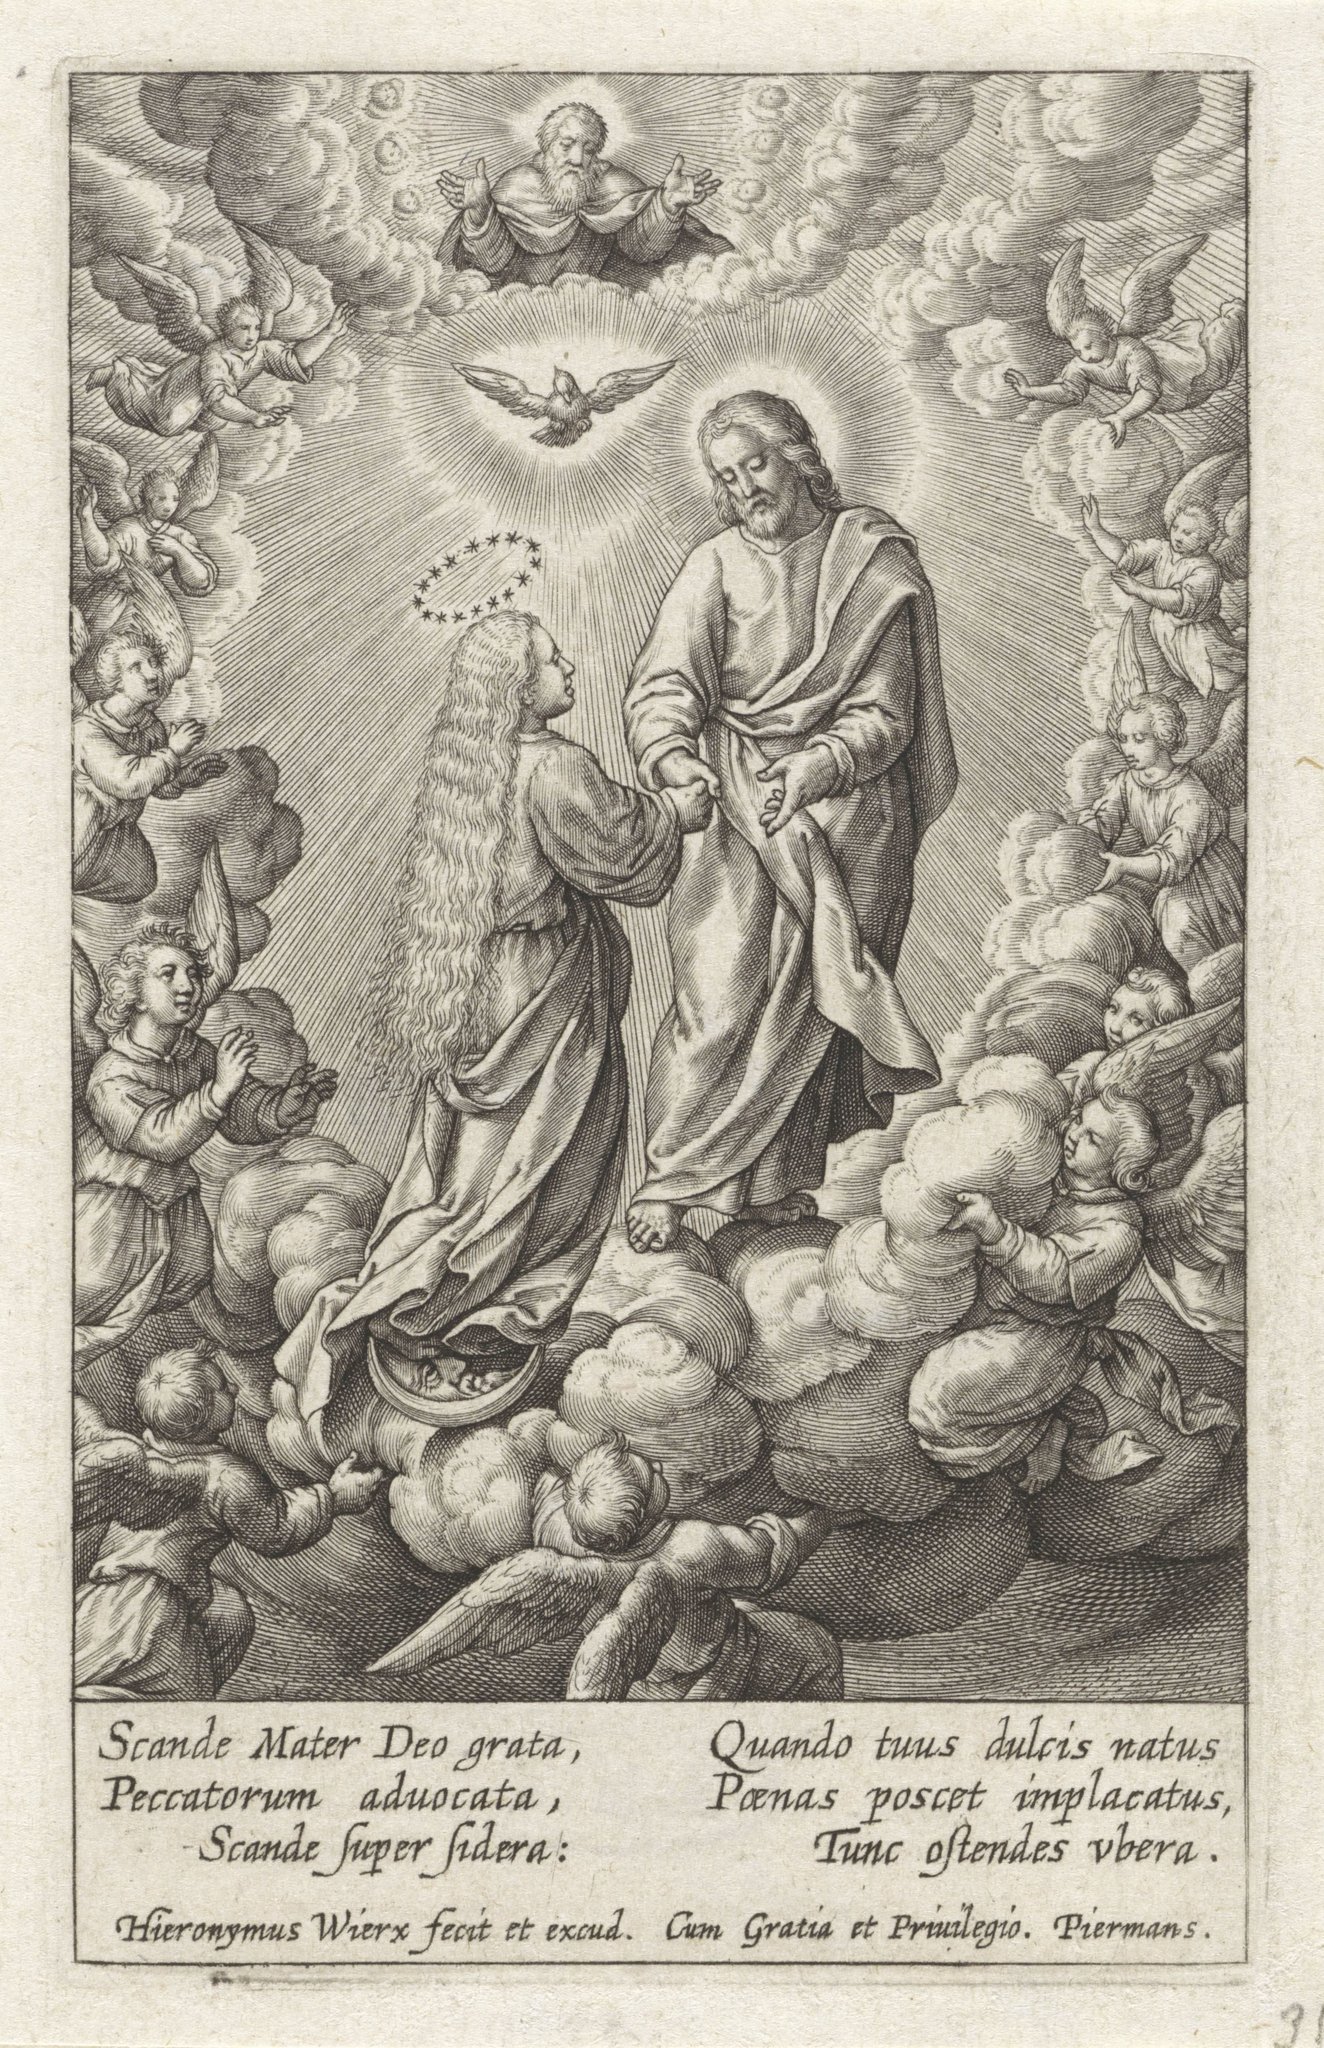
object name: print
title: Leven van de maagd Maria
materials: paper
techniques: engraving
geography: antwerp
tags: the assumption of mary ('assumptio corporis'): she is borne into heaven by angels (+ holy trinity)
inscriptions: collector's mark: Lugt 2228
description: Maria wordt op de maansikkel meegevoerd naar de hemel. Christus pakt haar hand vast. Boven hem de Heilige Geest als duif en God de Vader. Ze zijn omringd door engelen op de wolken. In de marge een zesregelig onderschrift, in twee kolommen, in het Latijn.